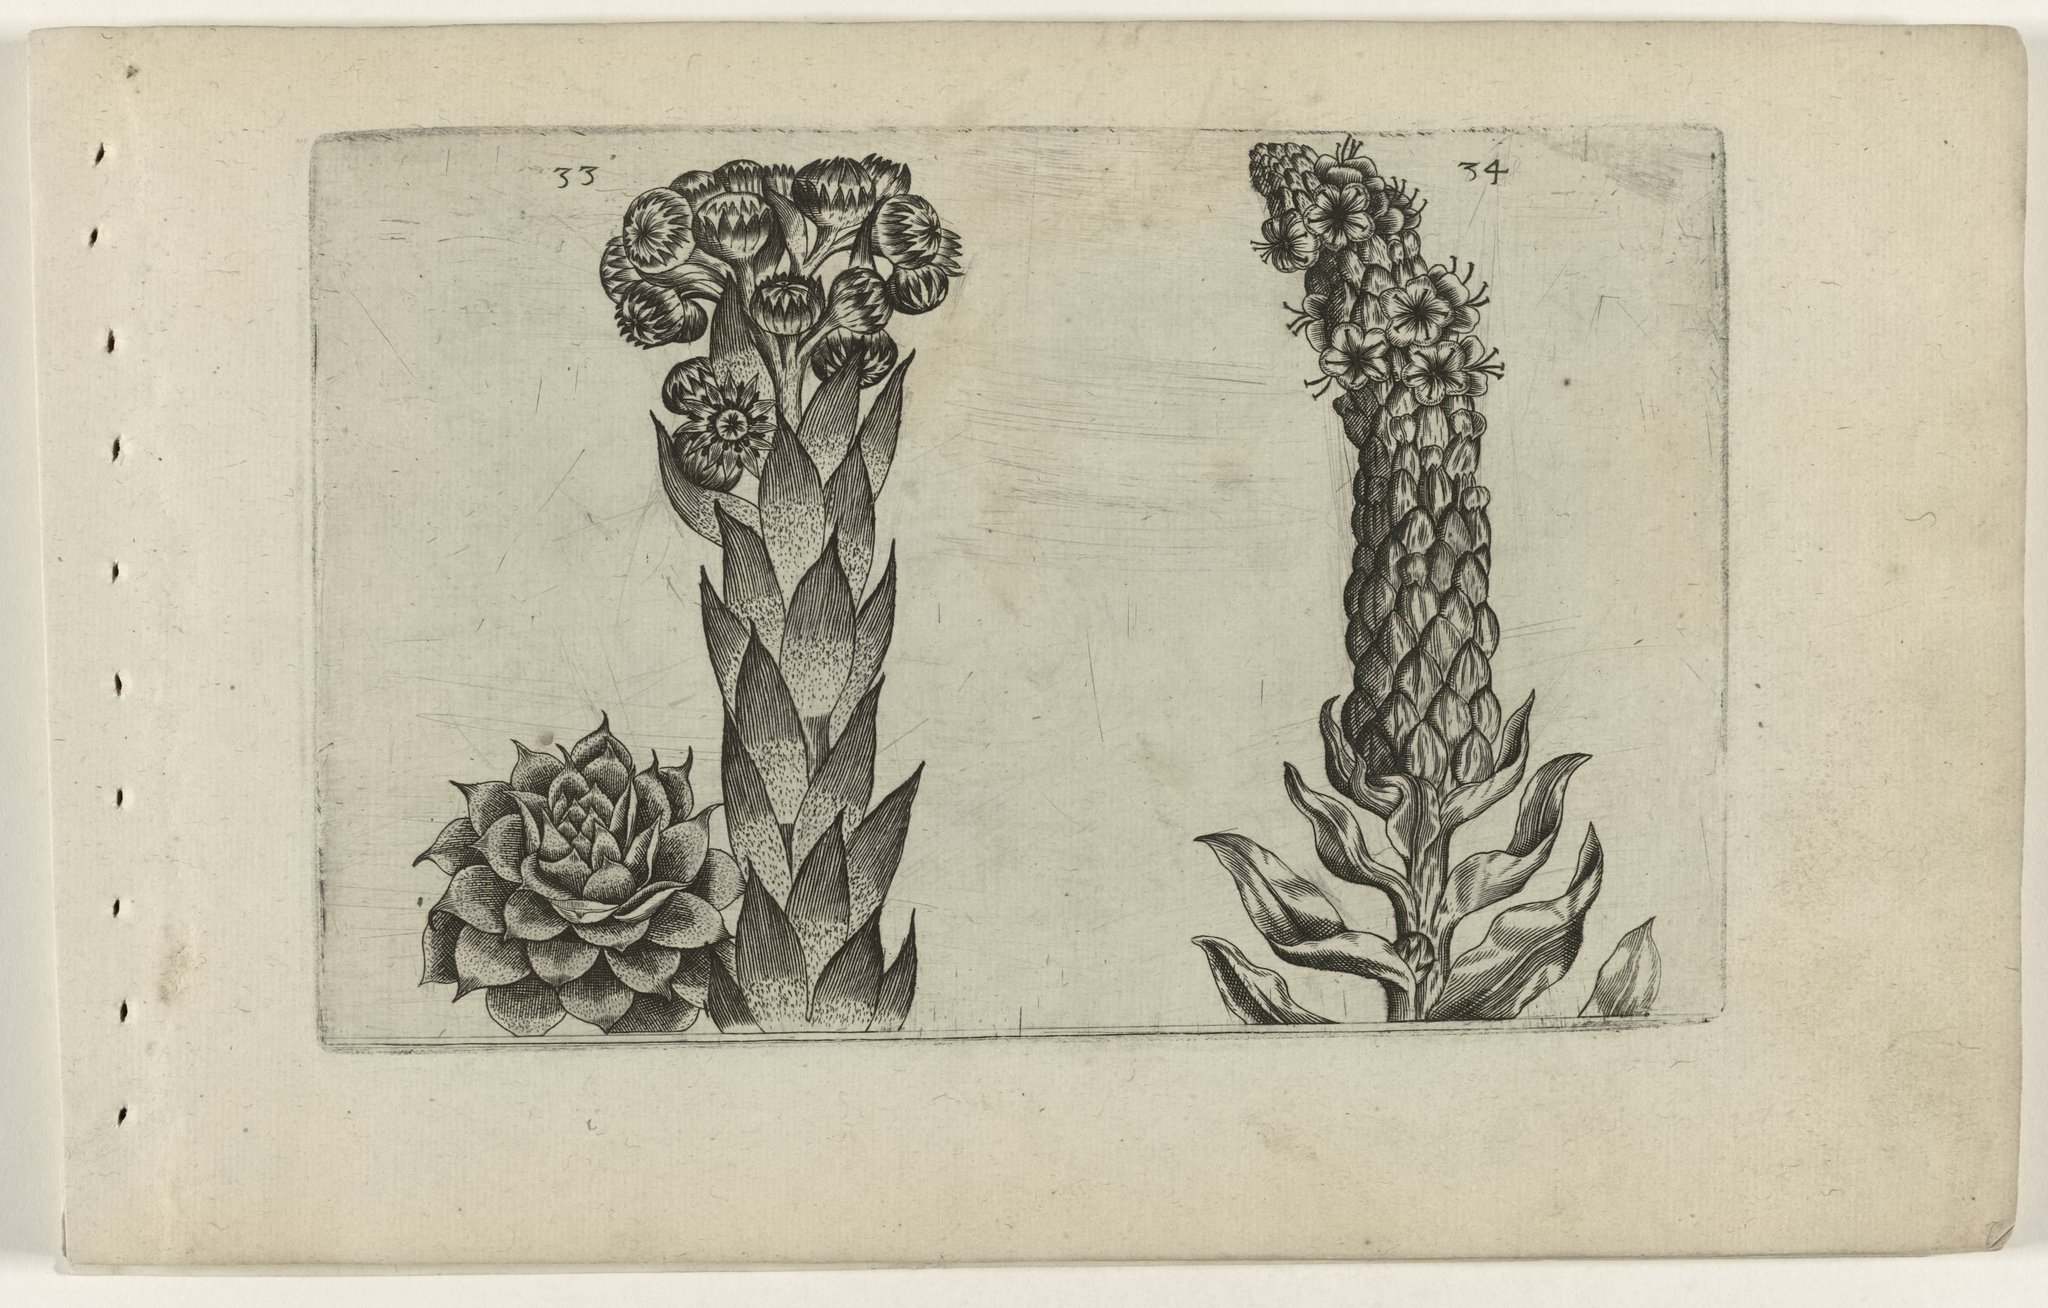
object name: print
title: Donderblad en koningskaars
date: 1600-1604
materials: paper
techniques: engraving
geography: cologne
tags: flowers: great mullein, flowers: sempervivum, botany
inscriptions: collector's mark: Lugt 2228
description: De prenten RP-P-2012-24-1 t/m 61 waren oorspronkelijk als serie samengebonden. De naaigaten op de bladen zijn nog zichtbaar. Het betreft de reeks getiteld: Cognoscite lilia, bestaande uit een titelprent en 60 gravures met 119 genummerde weergaven van planten, bloemen en vruchten, versierd met rinceaux en kleine voorstellingen van dieren. Het gaat om proefdrukken van deze reeks gravures, voor de opschriften en, deels, voor de nummering. Op enkele prenten zijn de nummers met de hand aangebracht. Op de titelprent ontbreekt nog het adres van Crispijn de Passe en Hans Woutneel. De titel is hoogstwaarschijnlijk gegraveerd door Matthias Quad. Deze werkte voor De Passe in Keulen tot 1604. De reeks moet in dit jaar of daarvoor tot stand zijn gebracht. In ieder geval voor 1608, aangezien de uitgever Hans Woutneel in of voor dat jaar overleed. In ieder geval voor 1608, aangezien de uitgever Hans Woutneel in of voor dat jaar overleed. De gravures worden door Ilja Veldman en Anthony Griffiths beschouwd als eigenhandig werk van Crispijn de Passe I. Een van de prenten uit de reeks ontbreekt (nr 21-22) en is vervangen door een ingekleurde afdruk uit een latere uitgave (RP-P-2012-24-61), die onder de titel Altera Pars is opgenomen in de Hortus Floridus, uitgegeven door Crispijn de Passe I en die verder bestaat uit platen van Crispijn de Passe II. De prenten afkomstig uit deze uitgave zijn op de verso voorzien van tekst in boekdruk. De vervangende prent maakte geen deel uit van de gebonden serie aangezien dit blad als enige geen naaigaten heeft. Een deel van de planten, bloemen en vruchten in de Cognoscite lilia gaat terug of is gebaseerd op een reeks aquarellen van Jacques LeMoyne uit circa 1580 en uit 1585, nu in het Victoria and Albert Museum en de British Museum (zie P. Hulton, Jacques LeMoyne, Londen 1977, dl 1, p. 156-162 en p. 165-173).